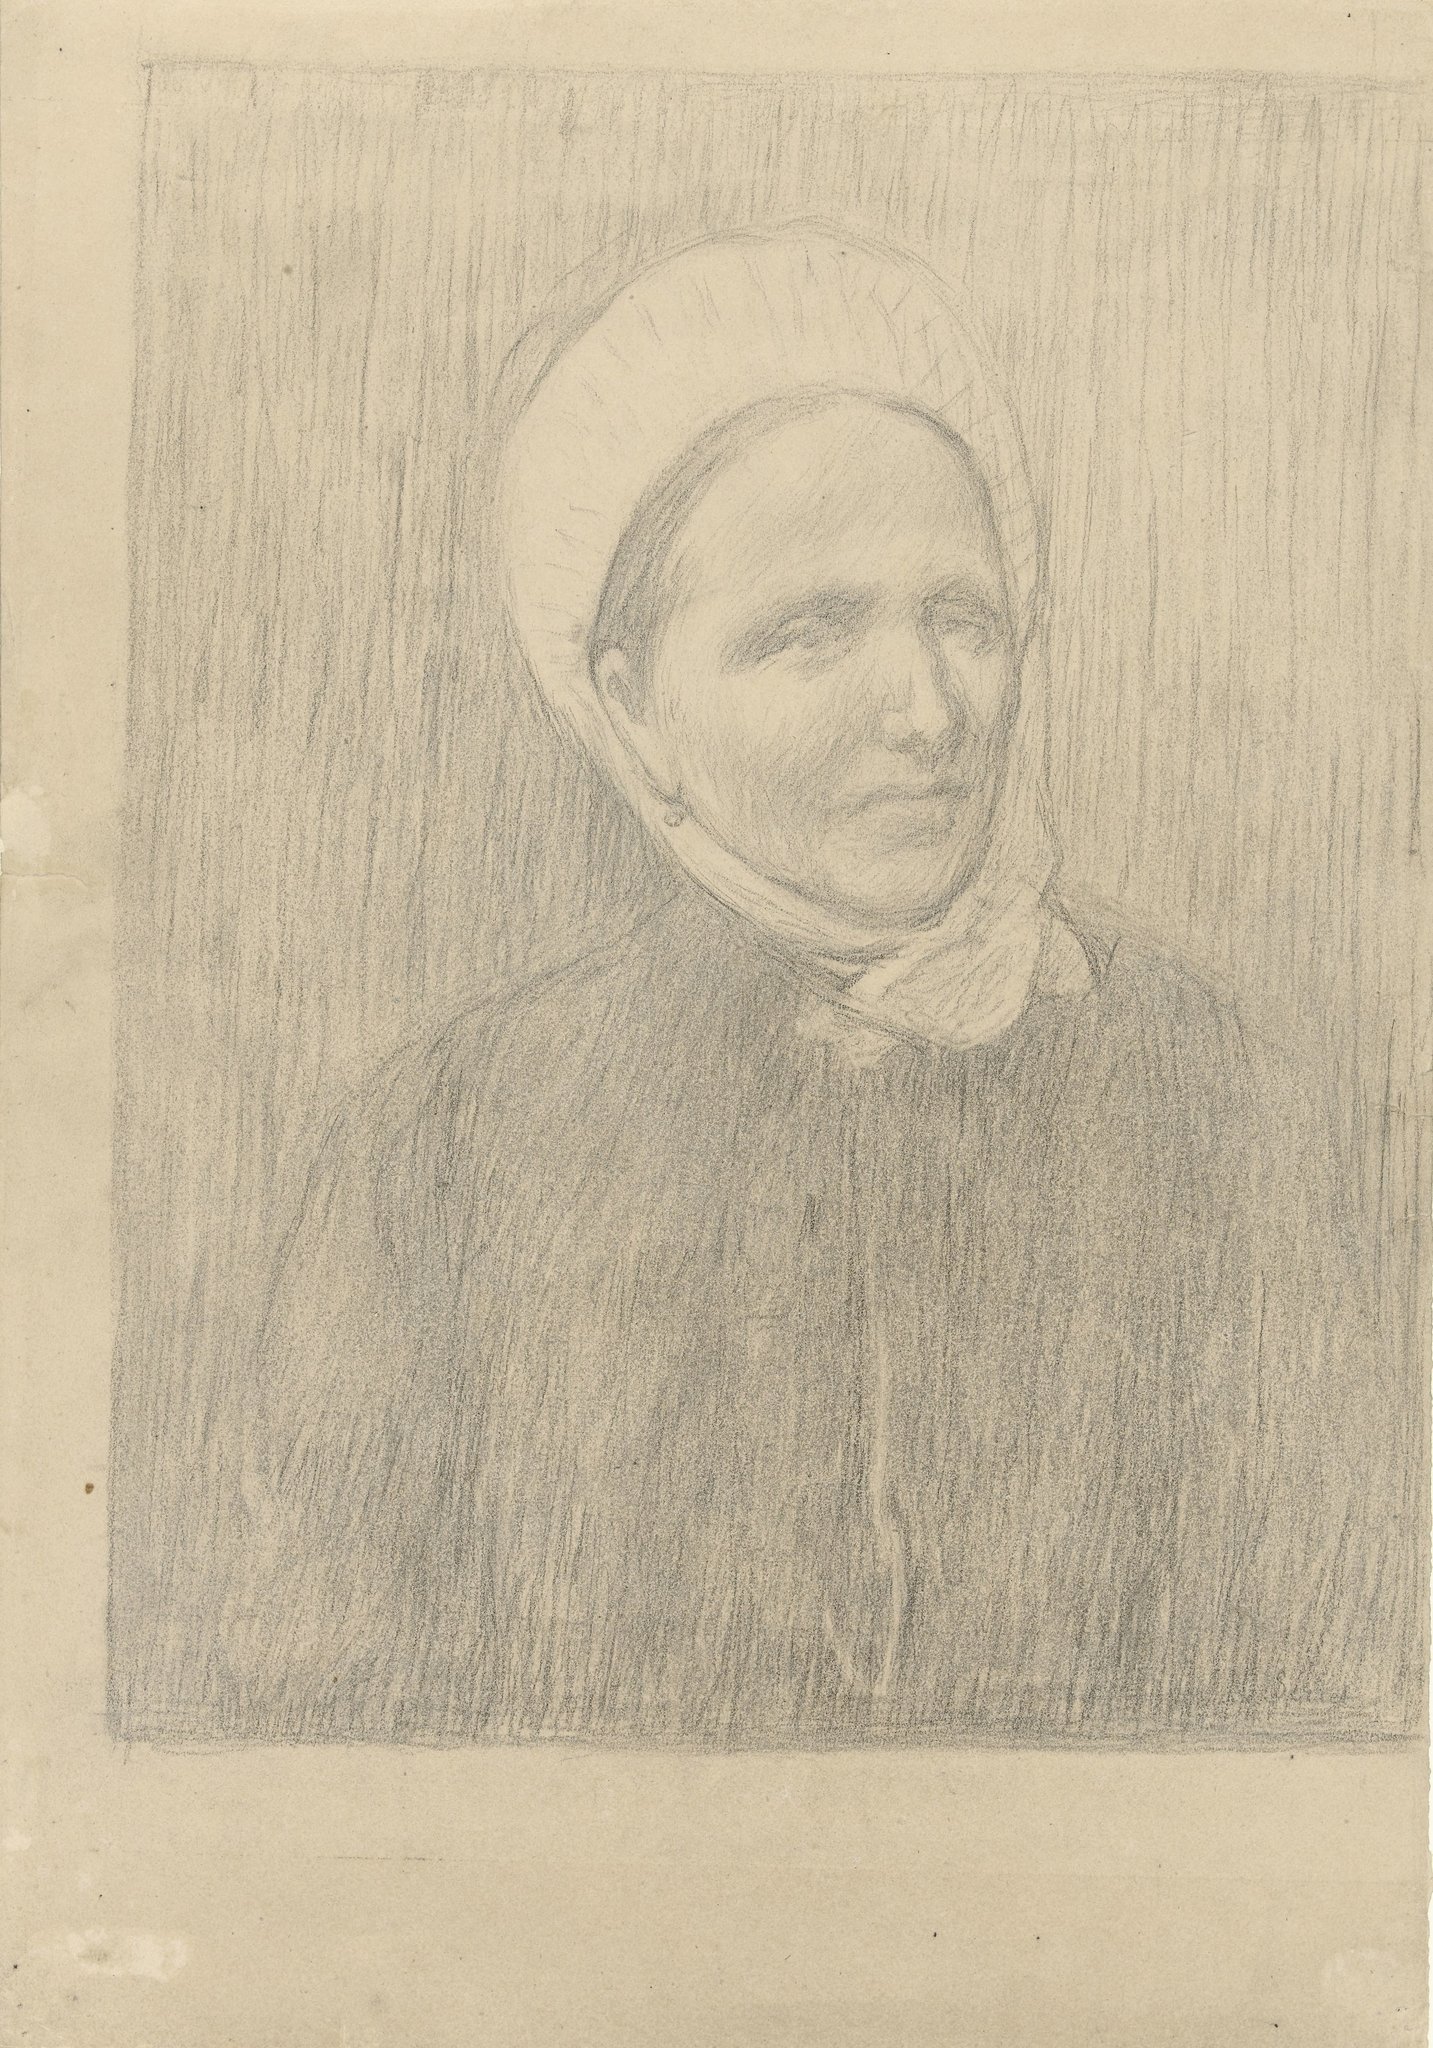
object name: drawing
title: Portret van Mevrouw Annie Bonger-van der Linde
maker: charles emmanuel serret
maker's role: draughtsman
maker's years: 1824-1900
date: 1800-1900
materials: chalk, paper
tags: historical persons - bb - woman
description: Portret van Mevrouw Annie Bonger-van der Linde, de eerste vrouw van André Bonger; borststuk, enigszins naar links en toeschouwer aanziend.